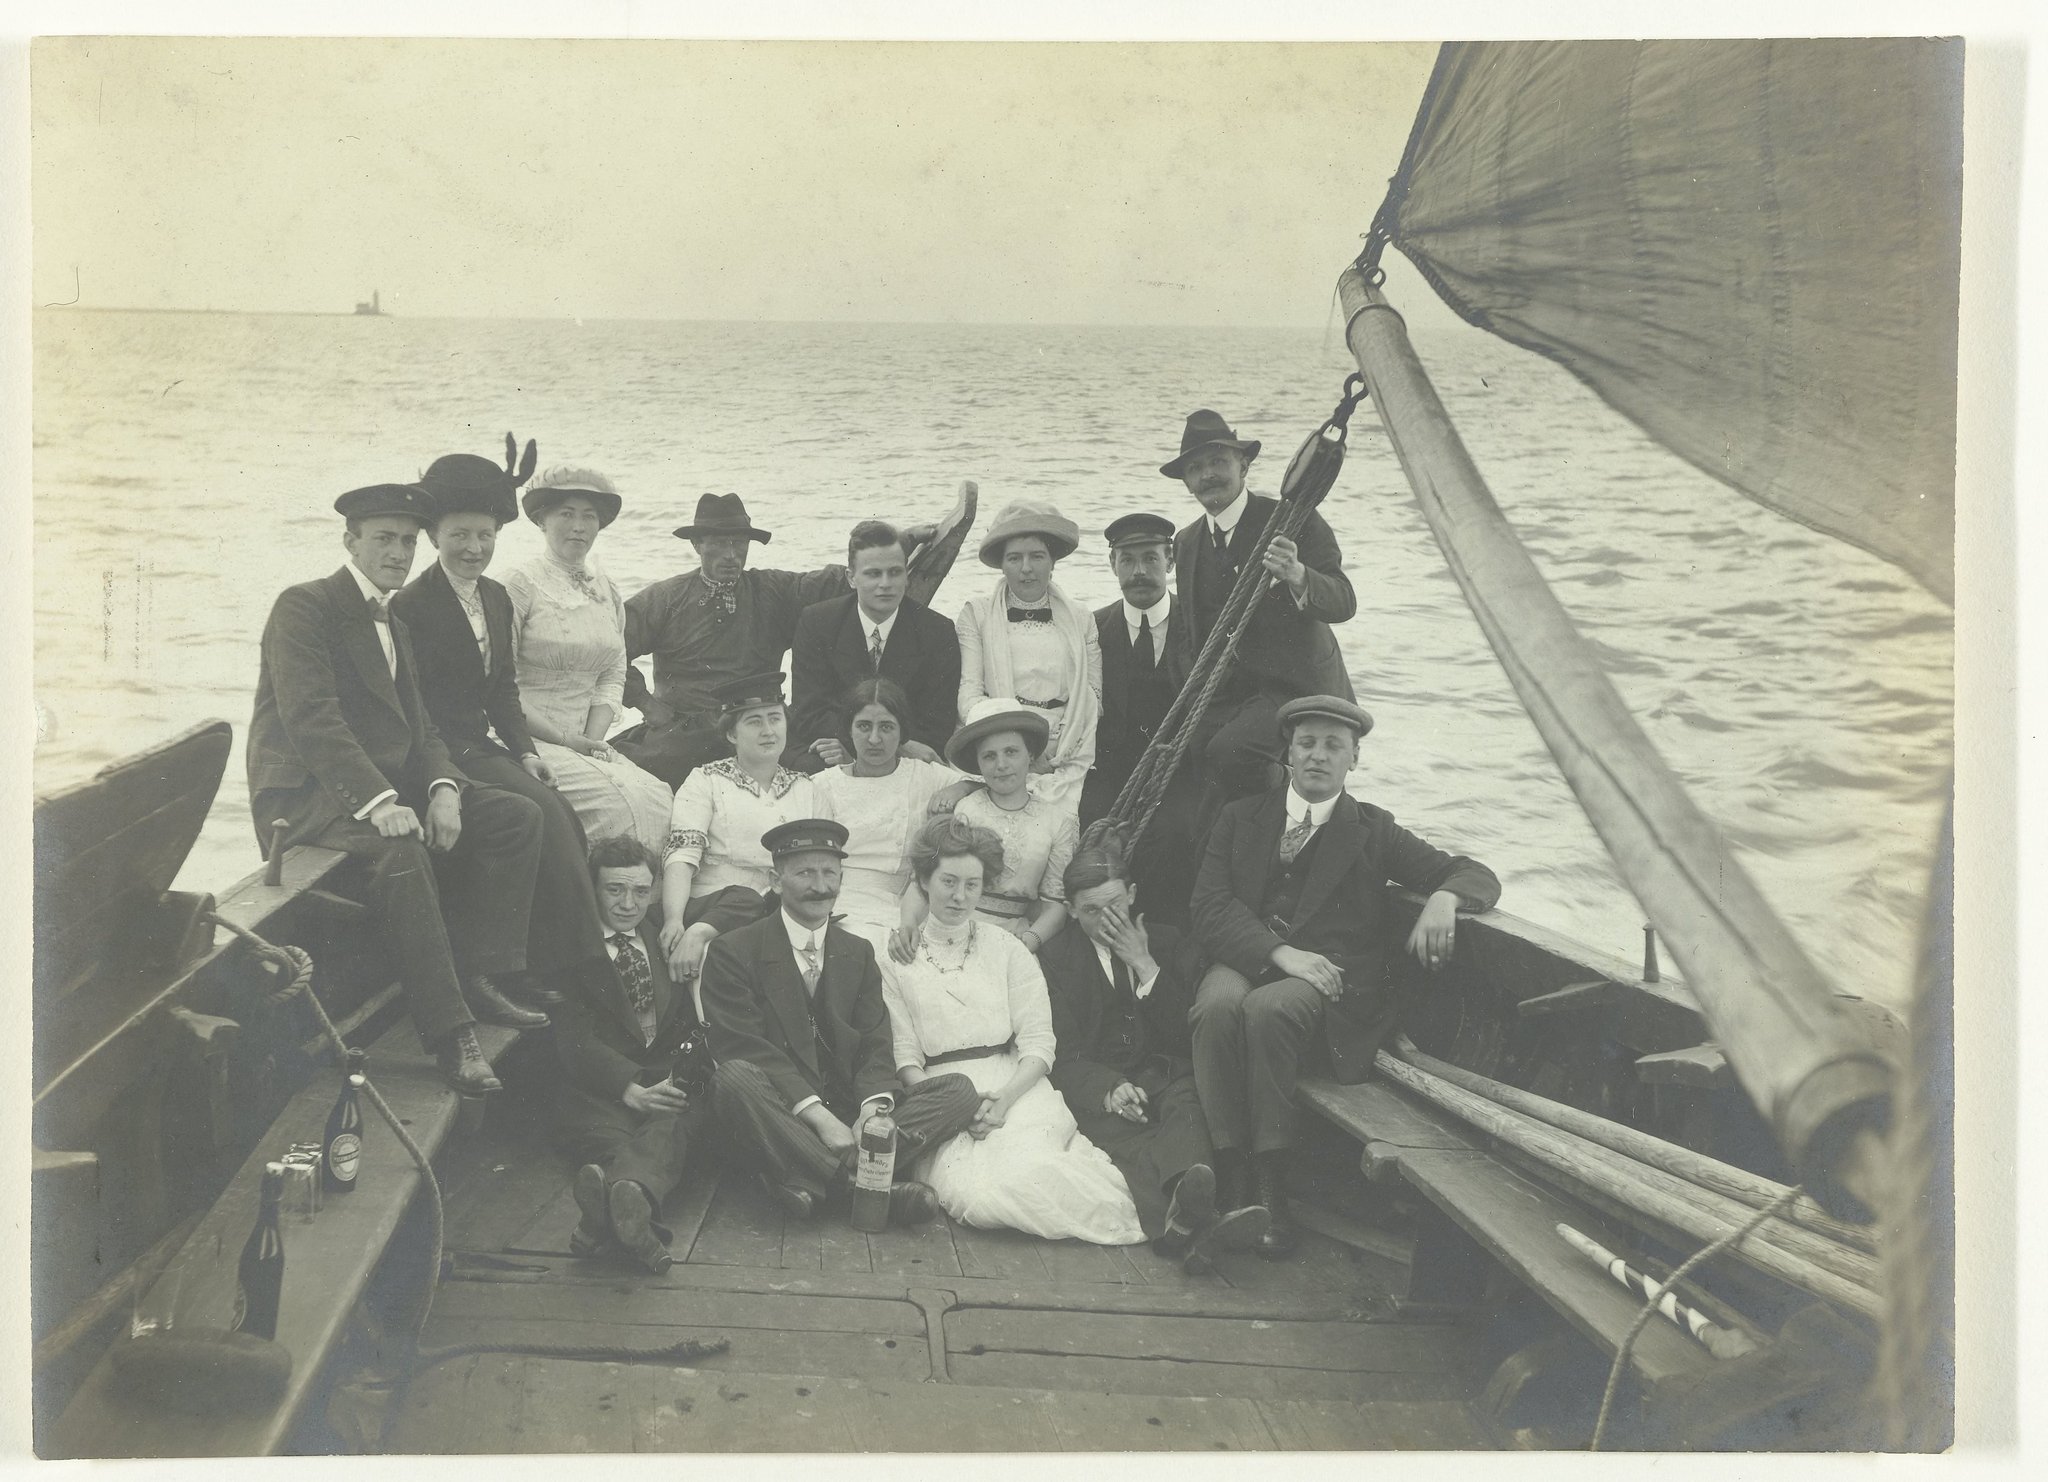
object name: photograph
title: Groepsportret van een gezelschap op een zeilschip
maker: Anonymous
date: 1915-1920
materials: photographic support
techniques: gelatin silver print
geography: netherlands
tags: anonymous historical persons portrayed in a group, in a group-portrait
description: Zeven vrouwen en negen mannen zittend op de achterplecht van een zeilschip. Links op de bank flesjes bier.